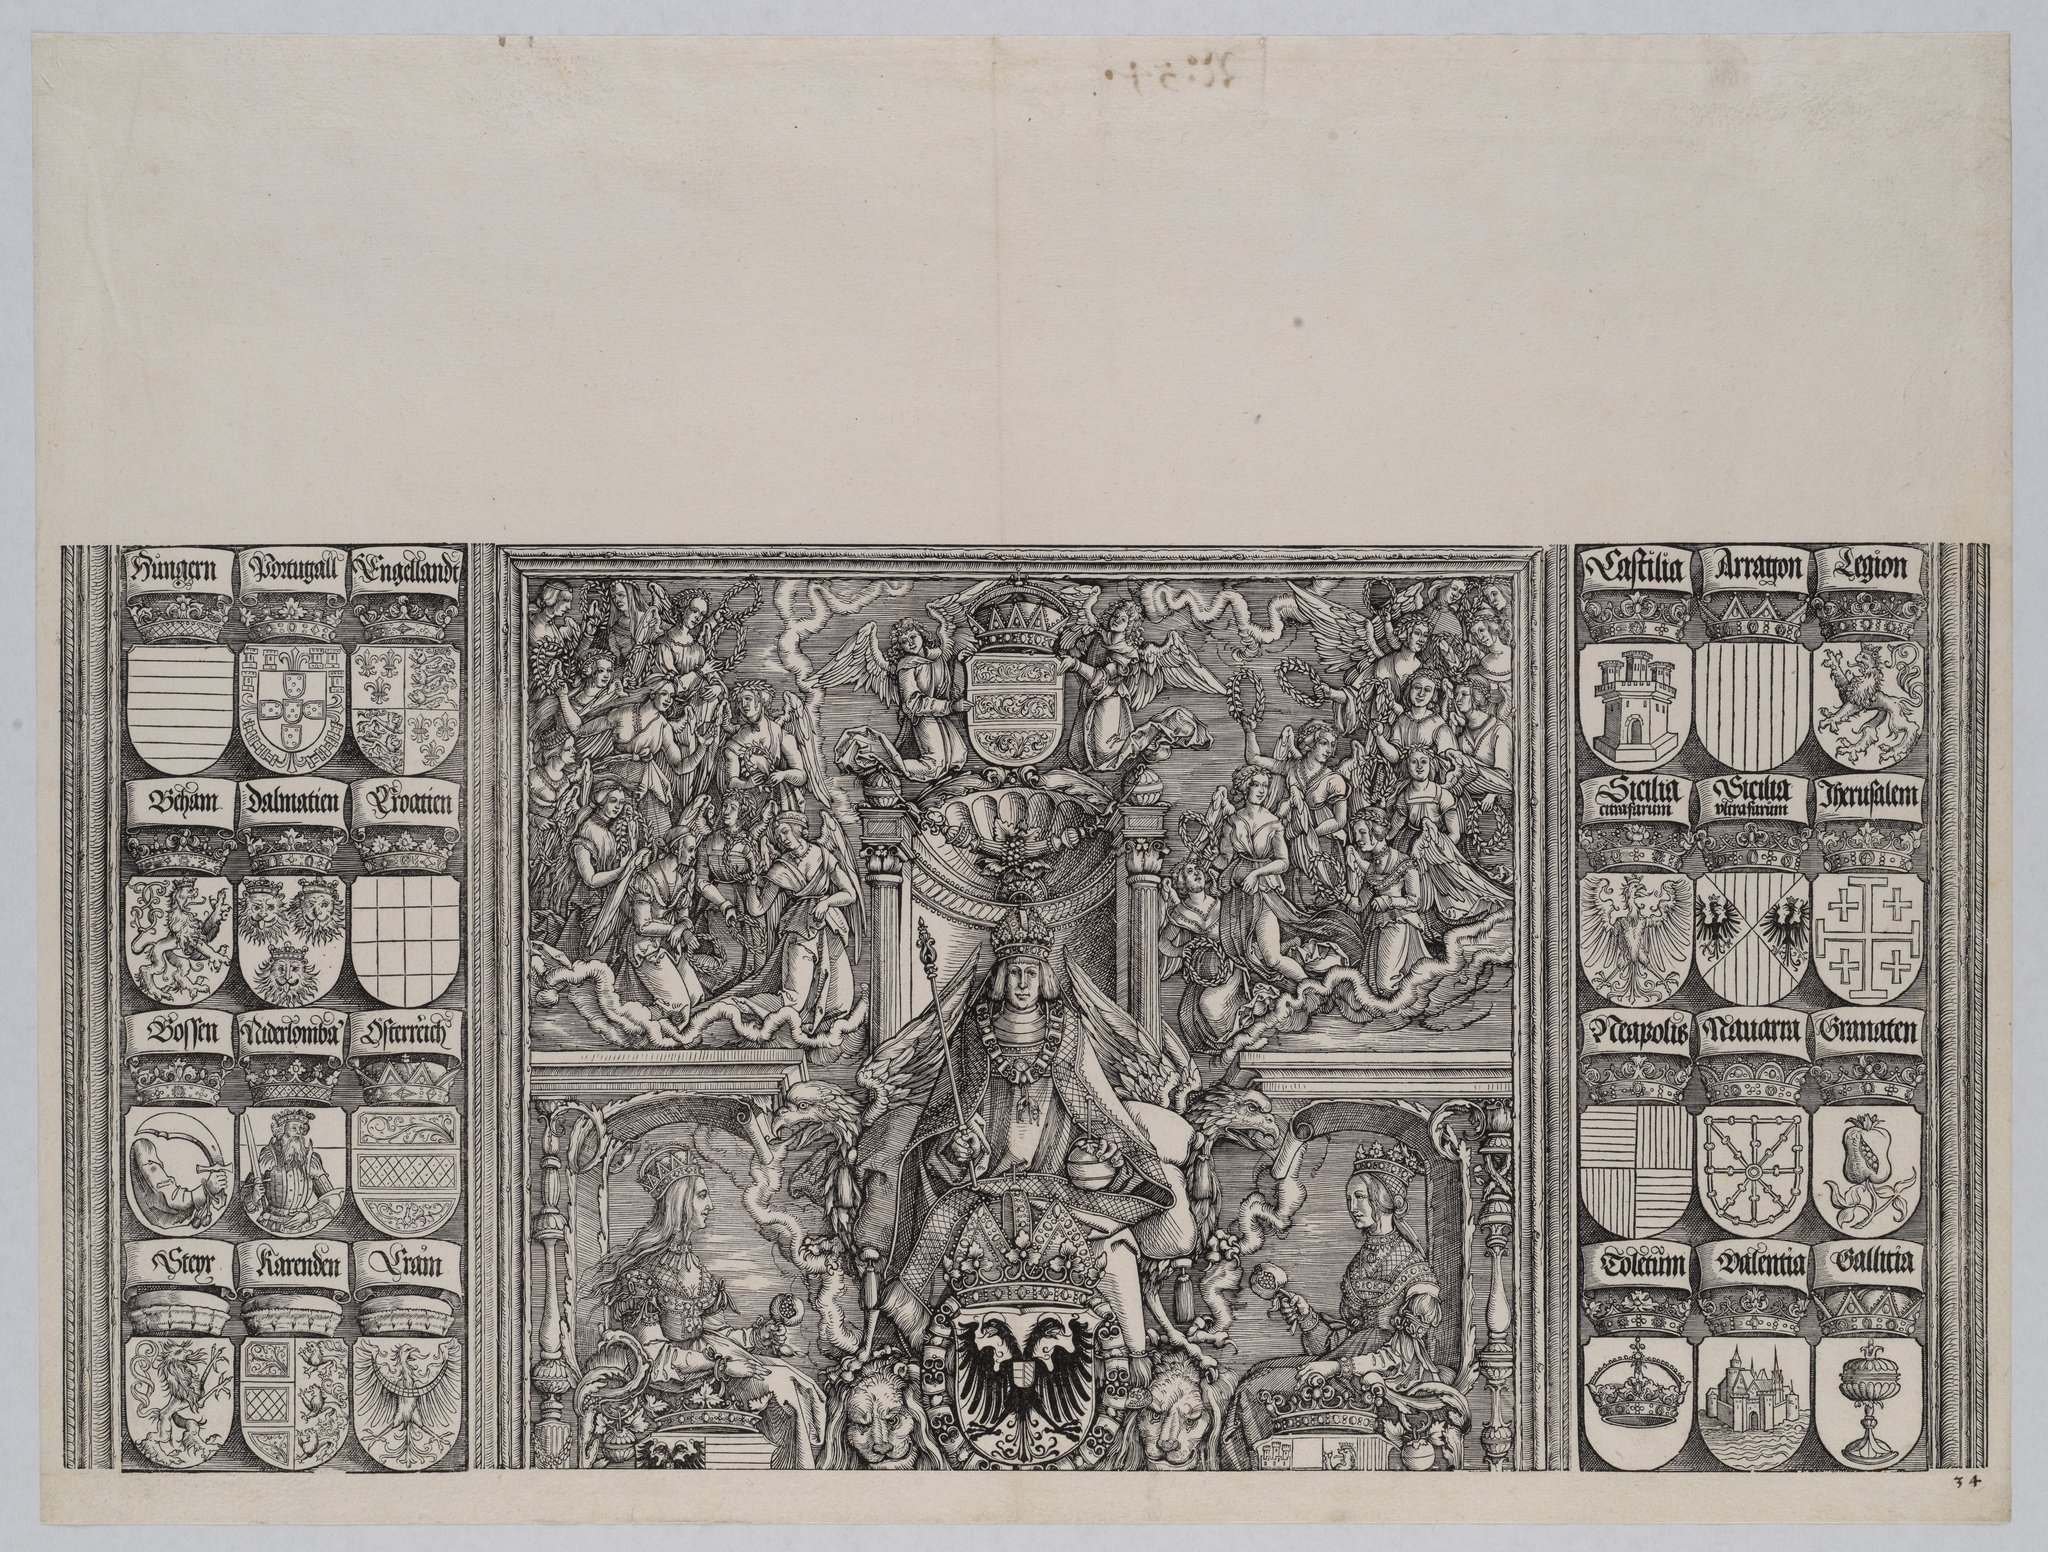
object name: print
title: The Emperor Seated on His Throne, Seated Between Joanna of Castile and Mary of Burgundy, Above Are Twenty-two Winged Victories; with Coats of Arms of Maximilian's Noble Relatives, from the Arch of Honor, proof, dated 1515, printed 1517-18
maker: hans springinklee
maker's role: artist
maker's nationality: german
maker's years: 1495-1530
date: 1515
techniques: letterpress, woodcut